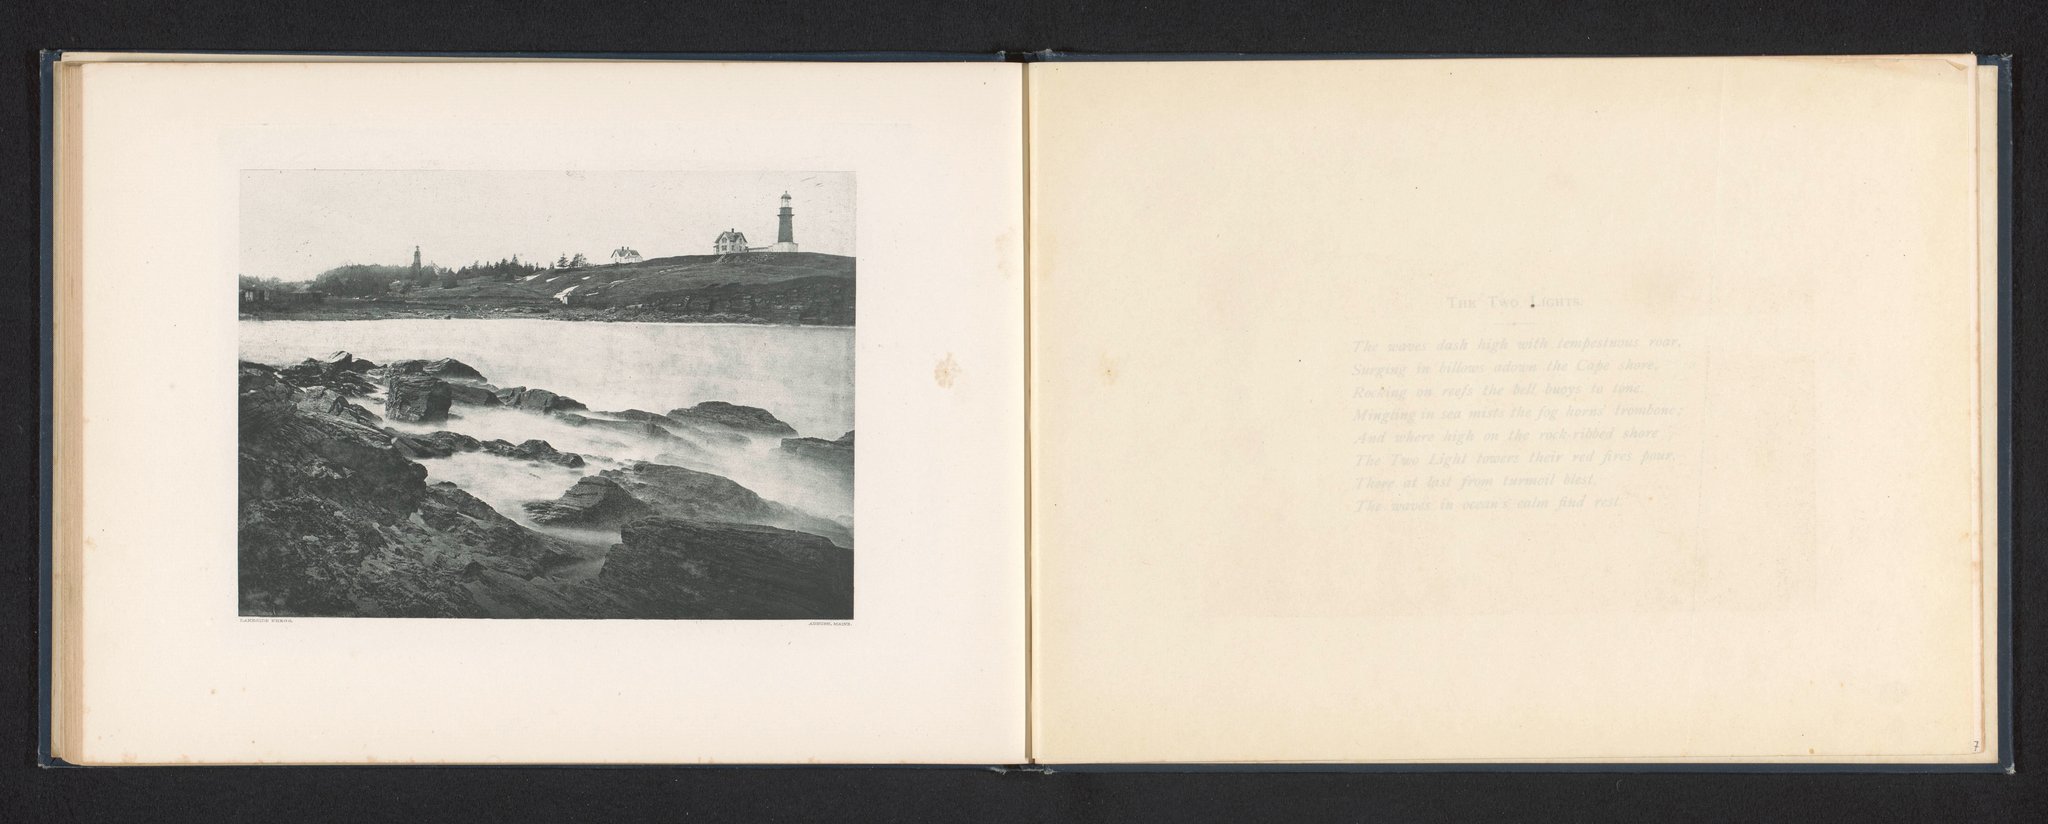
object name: page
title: Gezicht op Cape Elizabeth met twee vuurtorens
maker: Anonymous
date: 1880-1890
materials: paper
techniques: photoaquatint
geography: cape elizabeth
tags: lighthouse, lightship, rocky coast, sea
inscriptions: inscription: ‘The Two Lights. (...)’